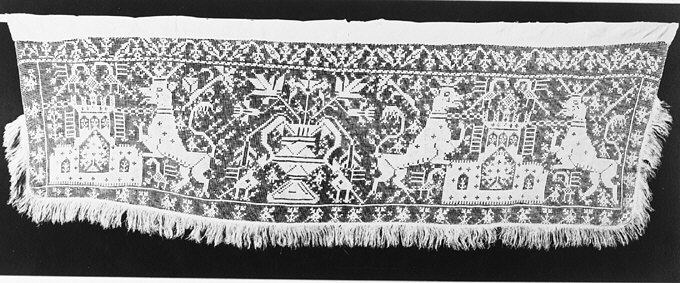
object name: valance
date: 1501-1600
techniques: embroidery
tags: animals